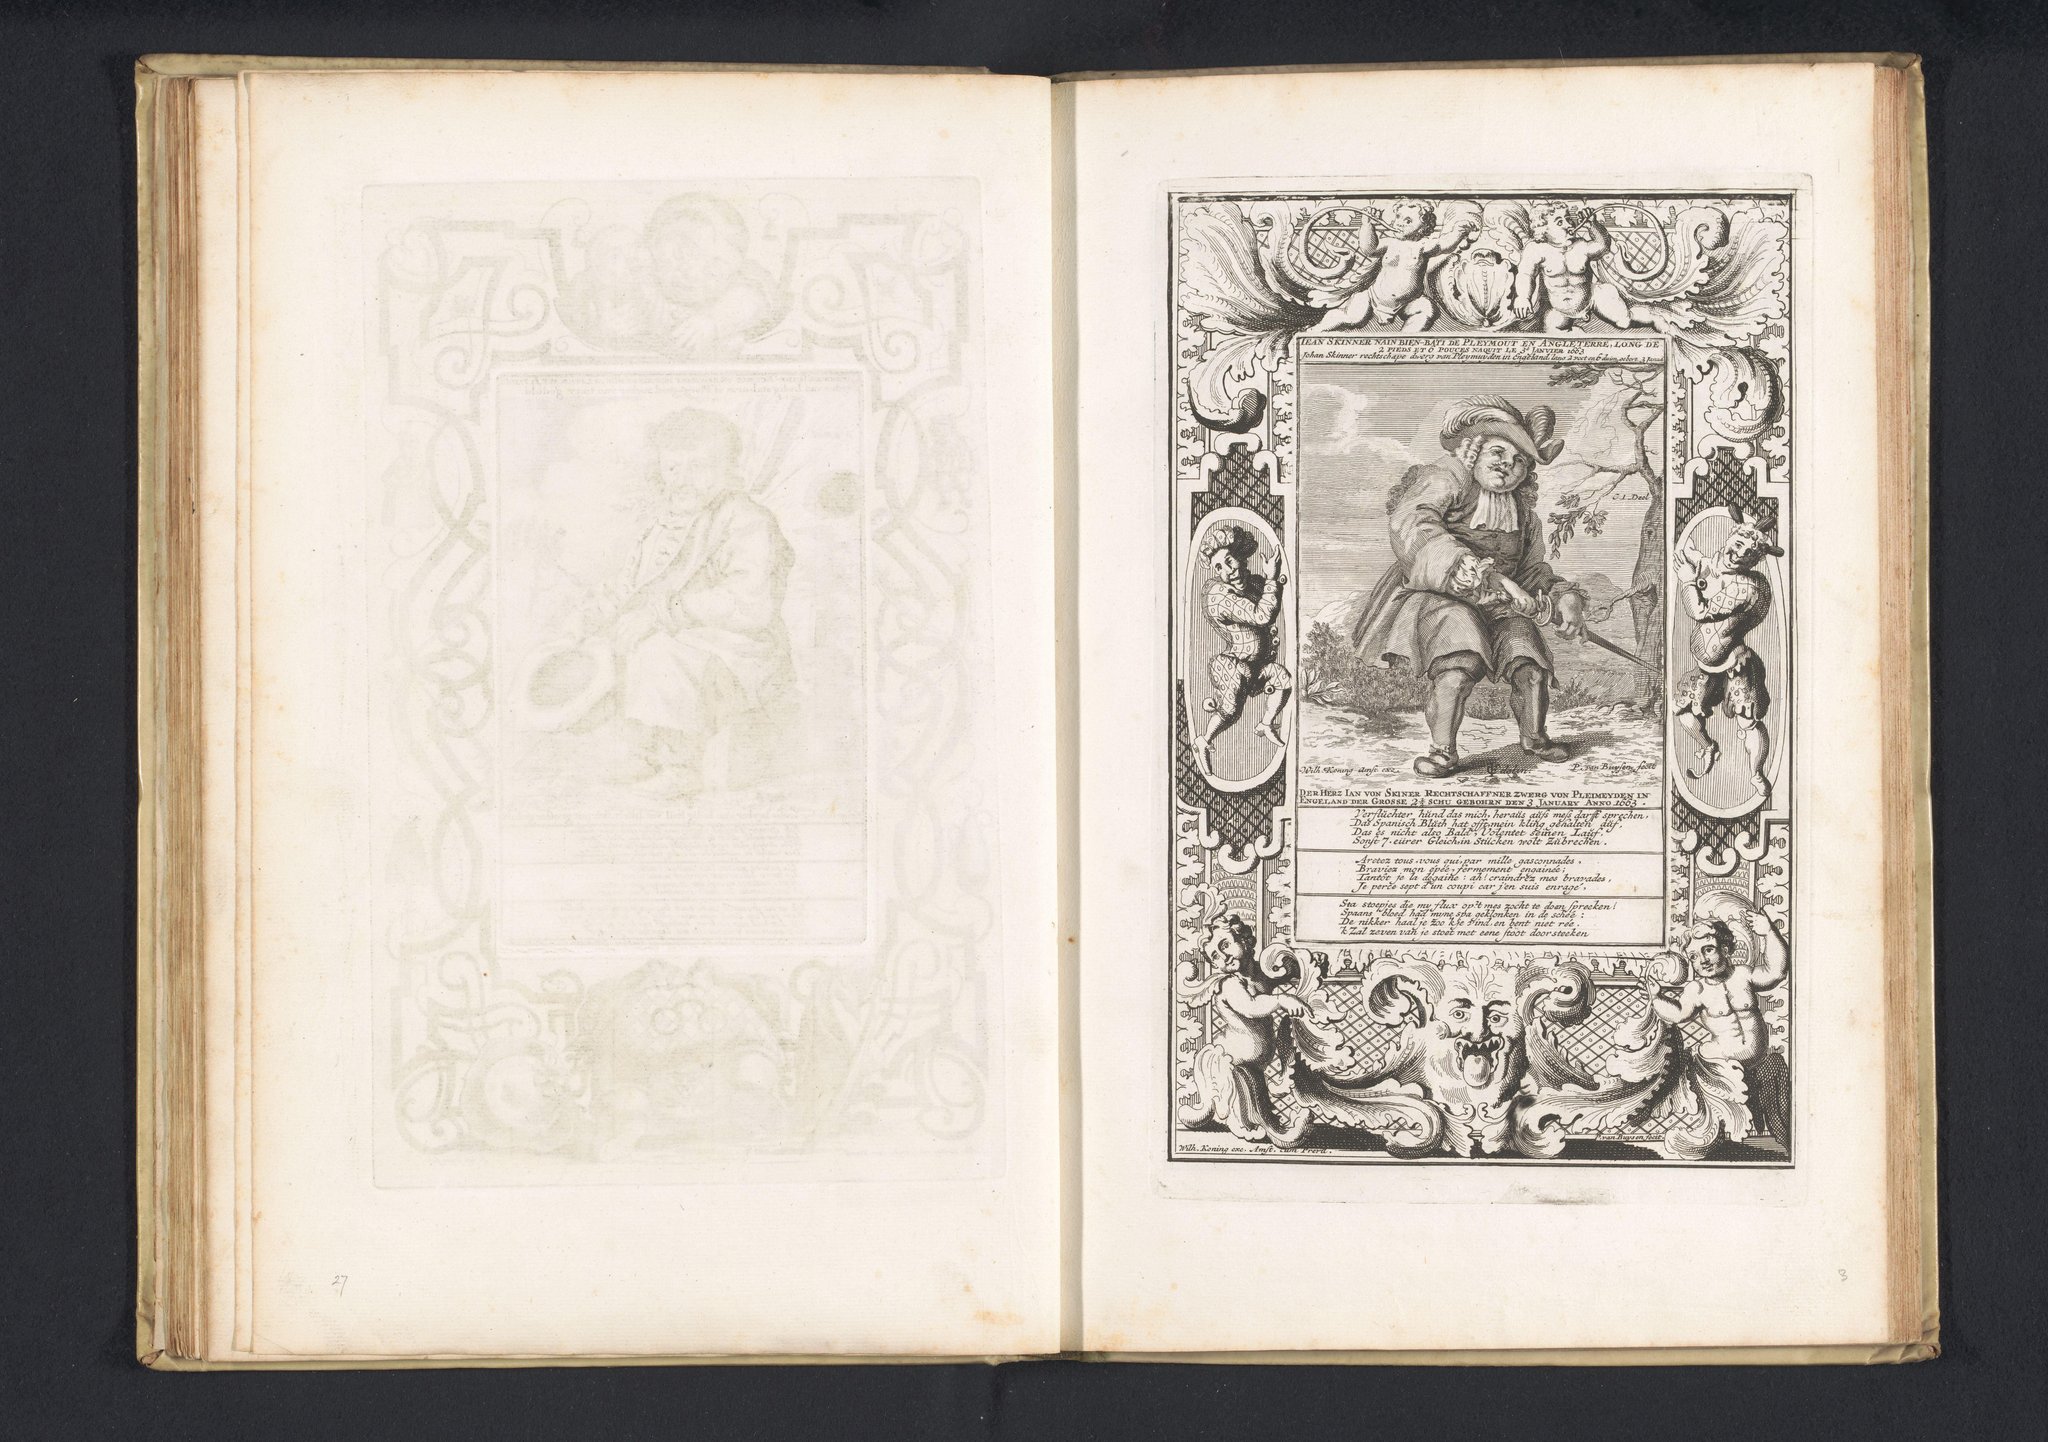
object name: print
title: Bombario Actionist en de Geest van Esopus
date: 1718-1720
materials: paper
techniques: engraving, etching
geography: amsterdam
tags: plymouth, little people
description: Portret van de Engelse kleine mens John Skinner, geboren te Plymouth in 1663. In het onderschrift verzen in het Duits, Frans en Nederlands. Genummerd: C. 1 Deel. Afdruk binnen een decoratieve omlijsting gedrukt van een aparte plaat met ranken en harlekijnen. Onderdeel van de tweede Nederlandse gebonden uitgave uit 1720 (en gerelateerd aan de Windhandel in dat jaar) van een serie karikaturen van kleine mensen, bekend als Het Dwergentooneel, deels gekopieerd naar een ouder Duits voorbeeld.